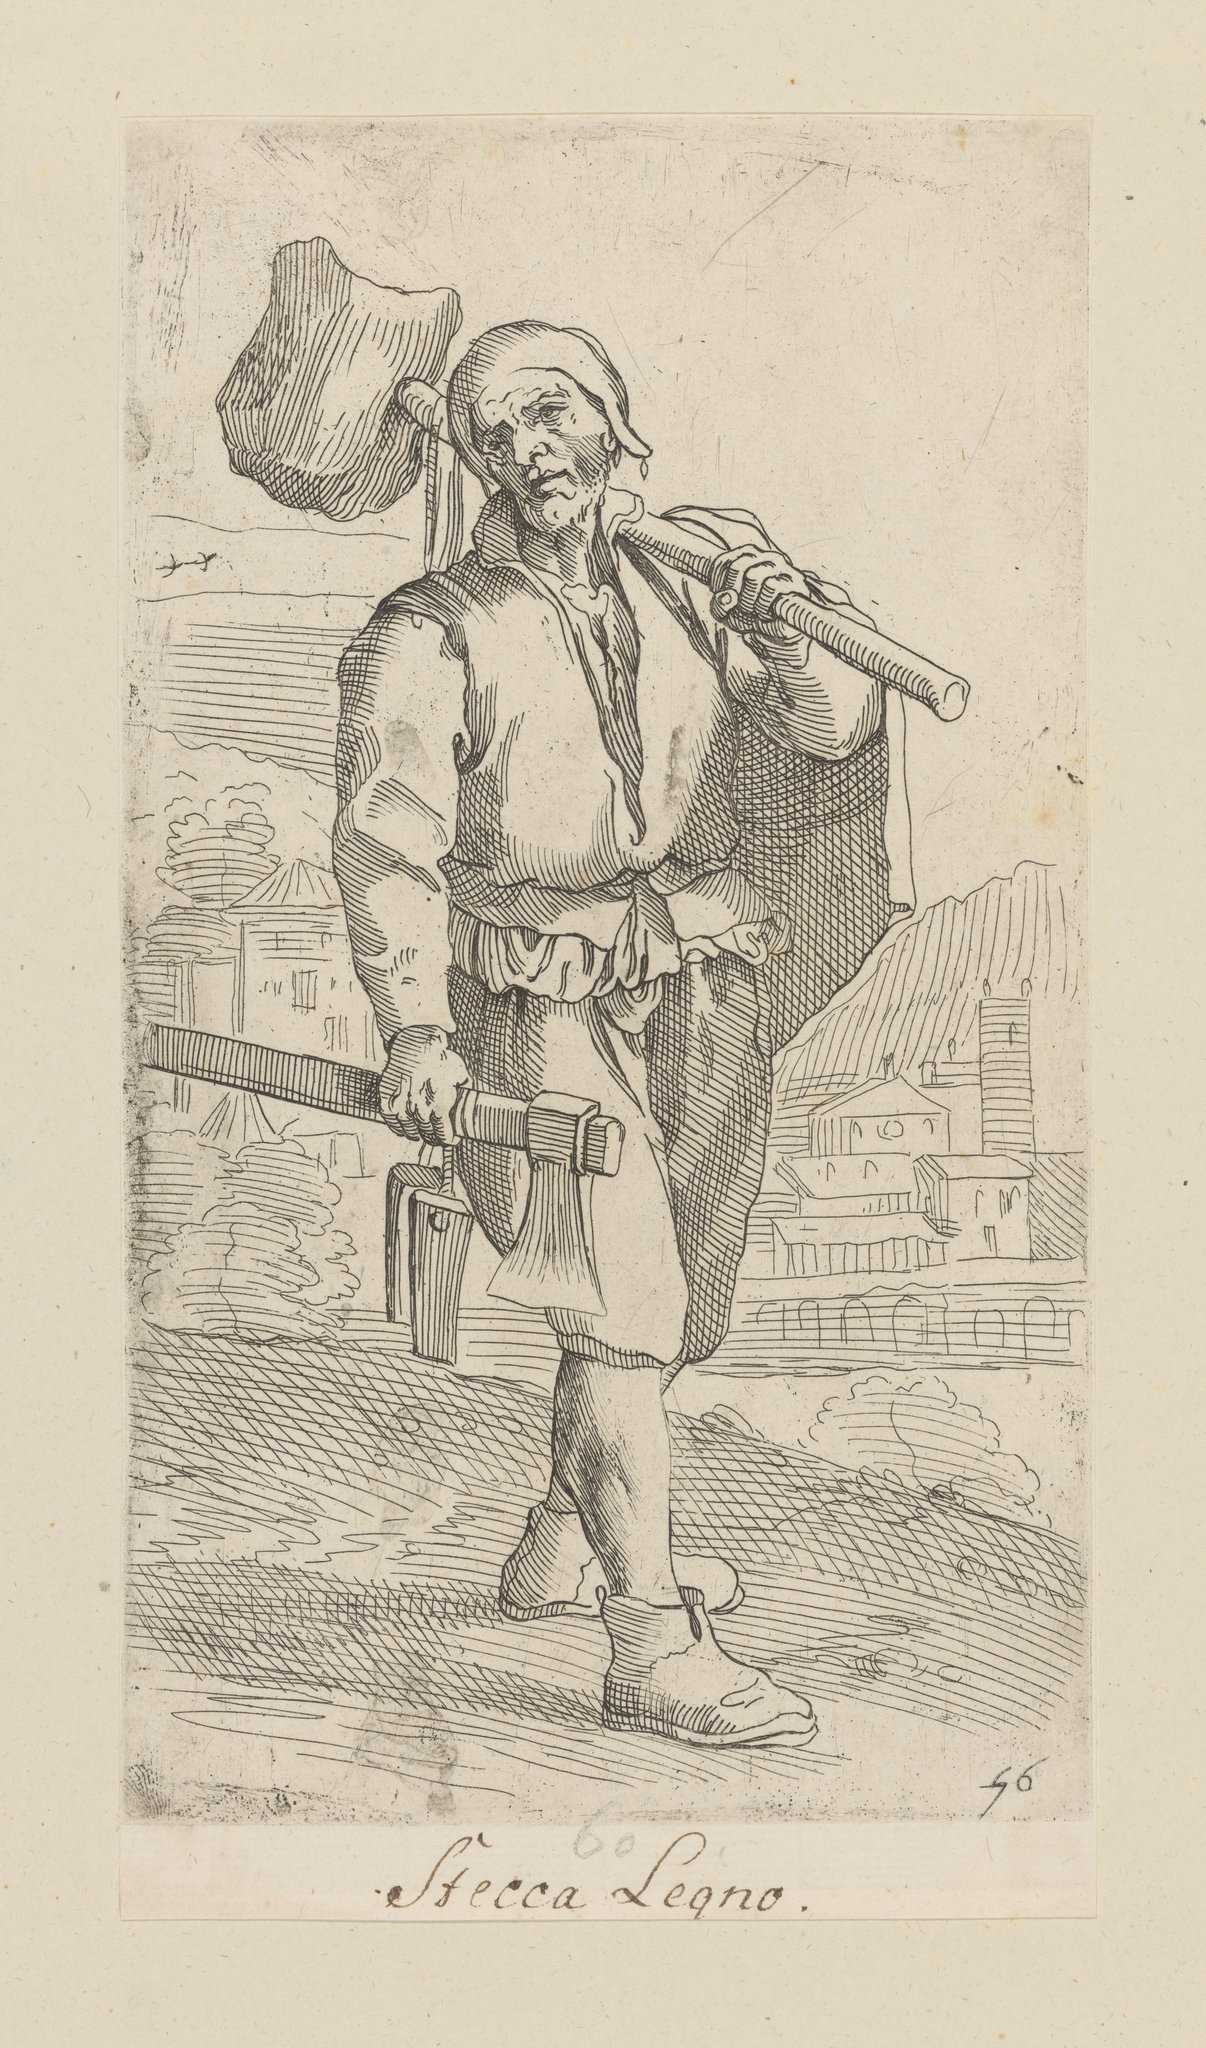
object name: print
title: Plate 56: Wood chopper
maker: simon guillain ii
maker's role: artist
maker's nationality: french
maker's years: 1618-1718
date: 1646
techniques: etching